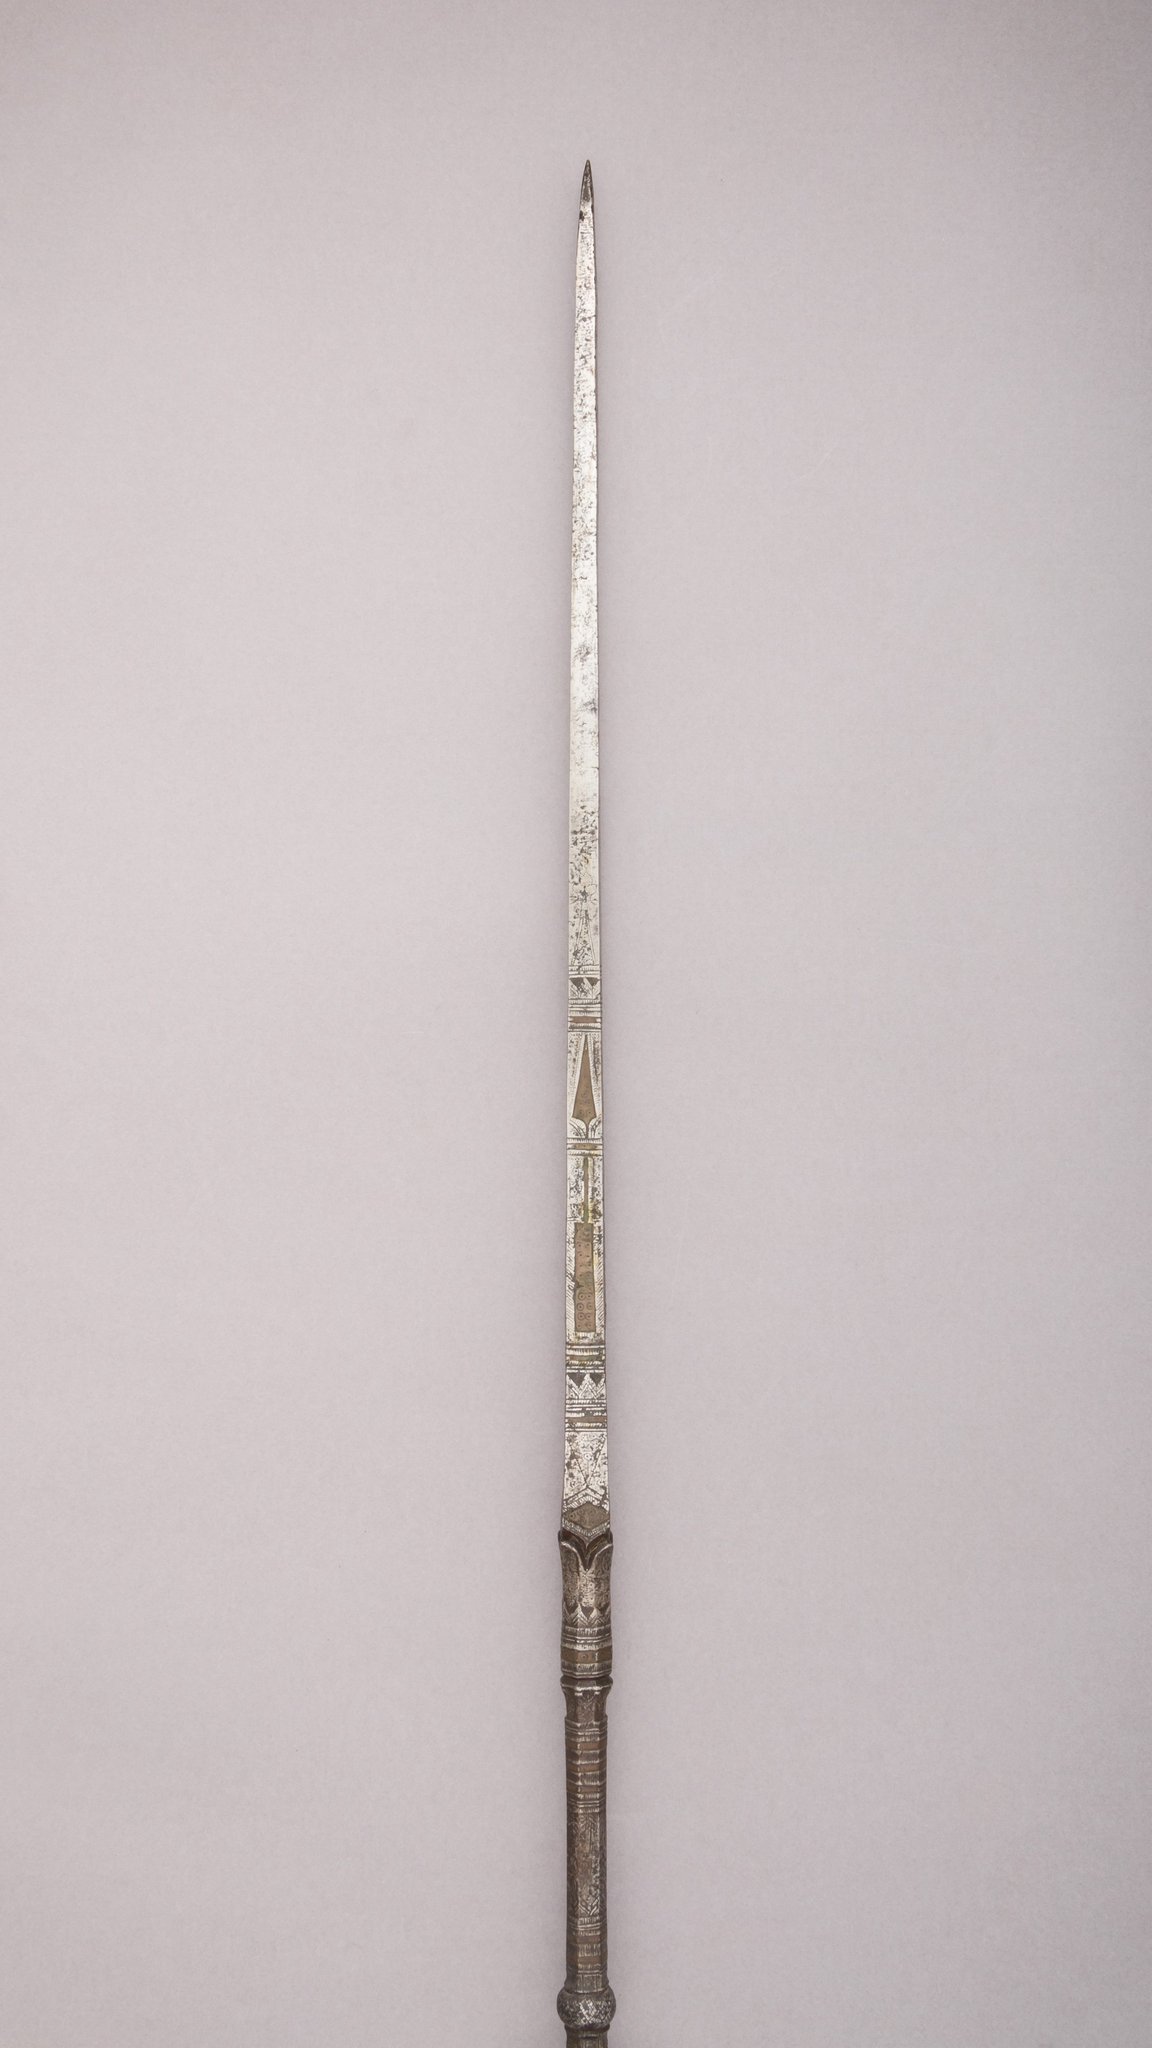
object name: spear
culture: indian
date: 1701-1900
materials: brass, steel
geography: india